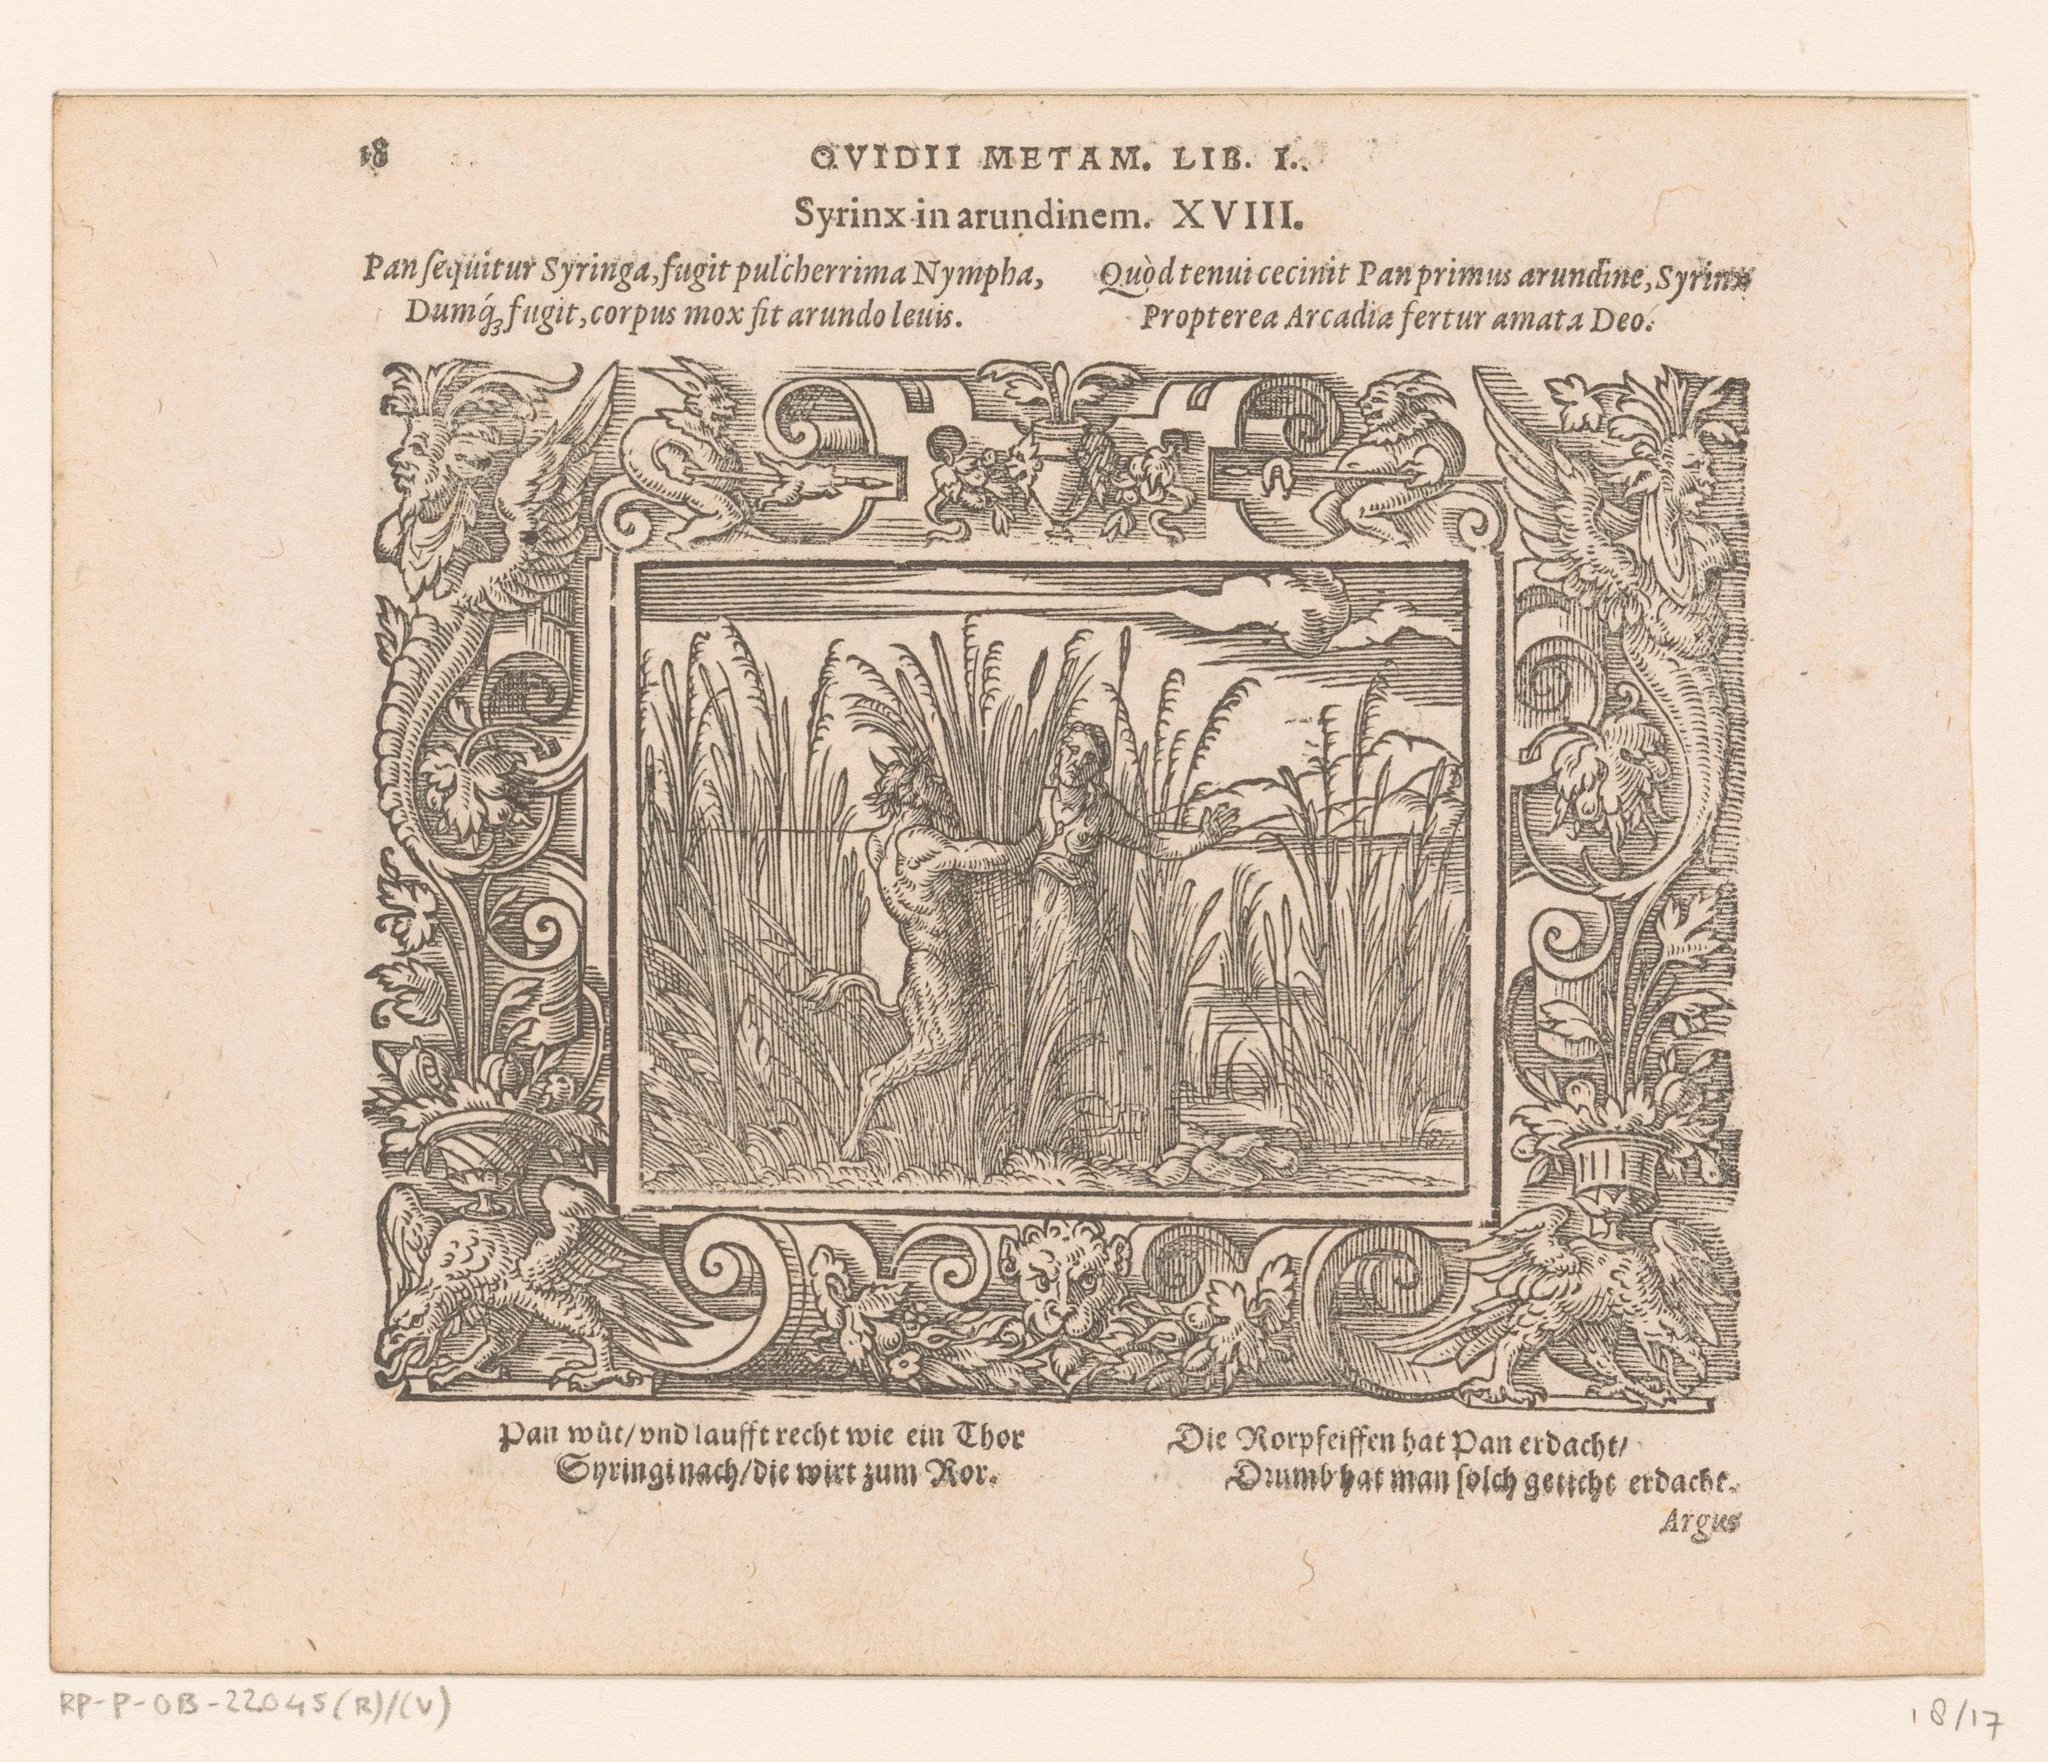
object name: book illustration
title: Syrinx in arundinem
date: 1569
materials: paper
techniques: letterpress printing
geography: nuremberg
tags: scrollwork, strapwork ~ ornament, syrinx changed into a reed: while fleeing from pan, the nymph syrinx is changed into reed by her sisters, the naiads (ovid, metamorphoses i 705)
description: Illustratie bij de Metamorfosen van Ovidius, afkomstig uit de publicatie: Posthius, Johannes. Tetrasticha in Ovidii metam. Frankfurt am Main: Georg Rab en Sigmund Feyerabend en erven Weigand Han, 1569. De voorstellingen en ornamentranden van deze boekillustraties zijn van twee aparte blokken gedrukt. Beide werden afzonderlijk van elkaar ook gebruikt voor andere publicaties, en de ornamentranden werden eveneens binnen deze publicatie meerdere keren gebruikt.